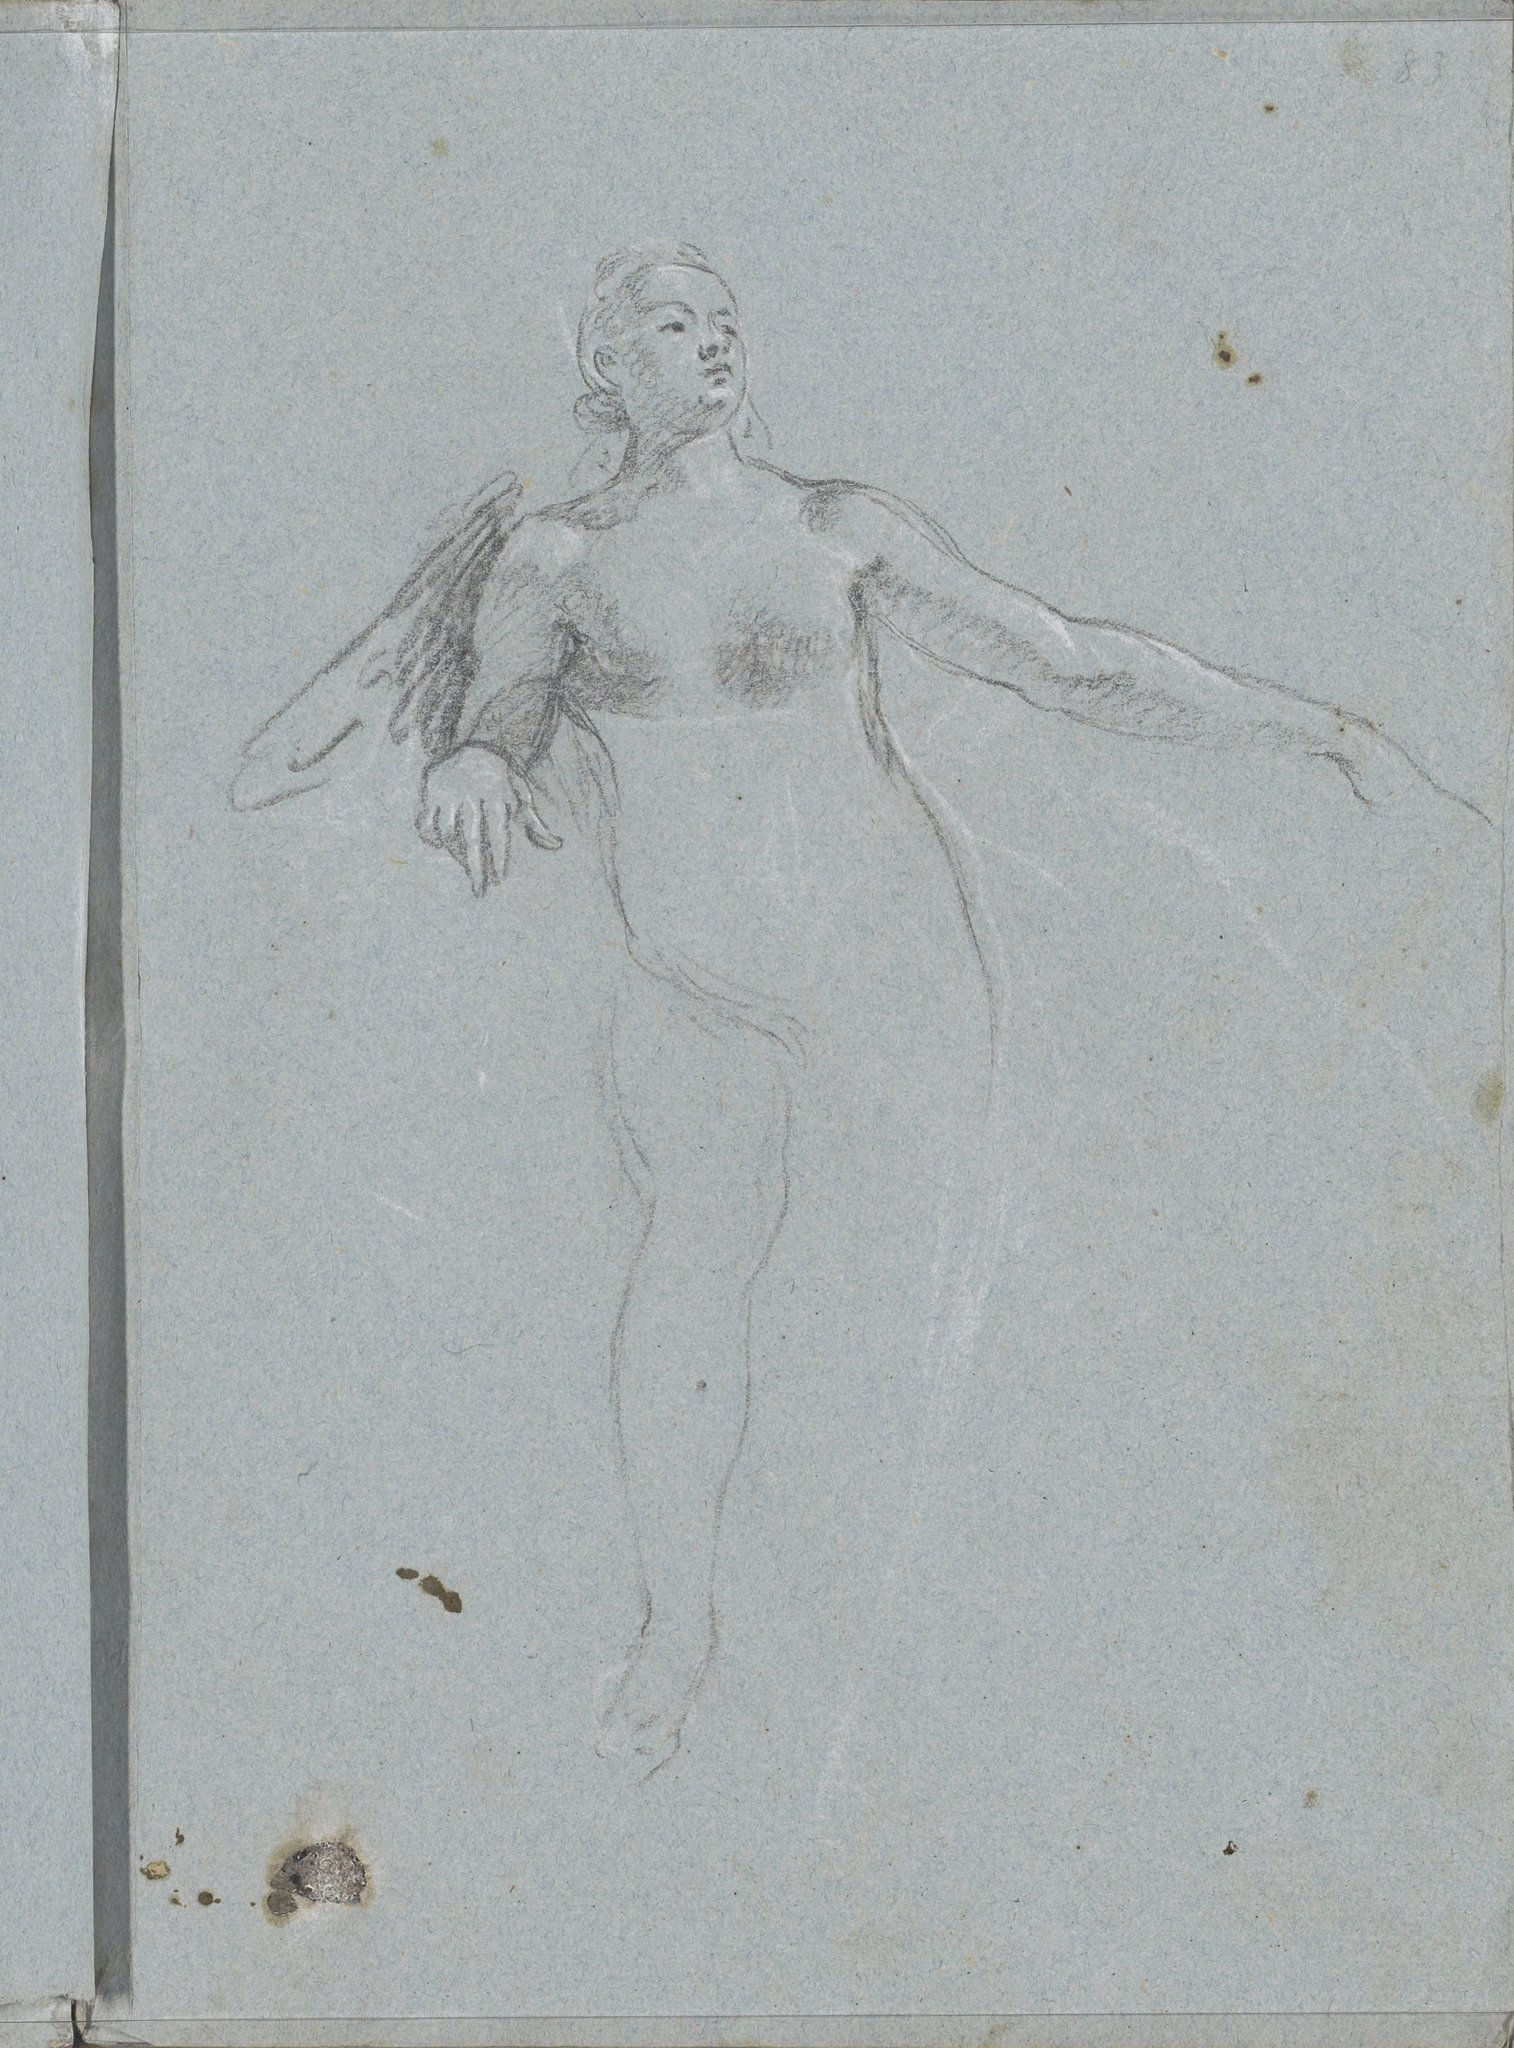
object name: sketchbook leaf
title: Gevleugelde naakte vrouw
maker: lorenzo baldissera tiepolo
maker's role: draughtsman, print maker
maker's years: 1736-1776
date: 1751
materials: chalk, paper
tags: female angels, the (nude) human figure; 'corpo humano' (ripa) - aa - female human figure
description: Mogelijk een vrouwelijke engel. Bladzijde 83 uit een schetsboek met 158 bladzijden.